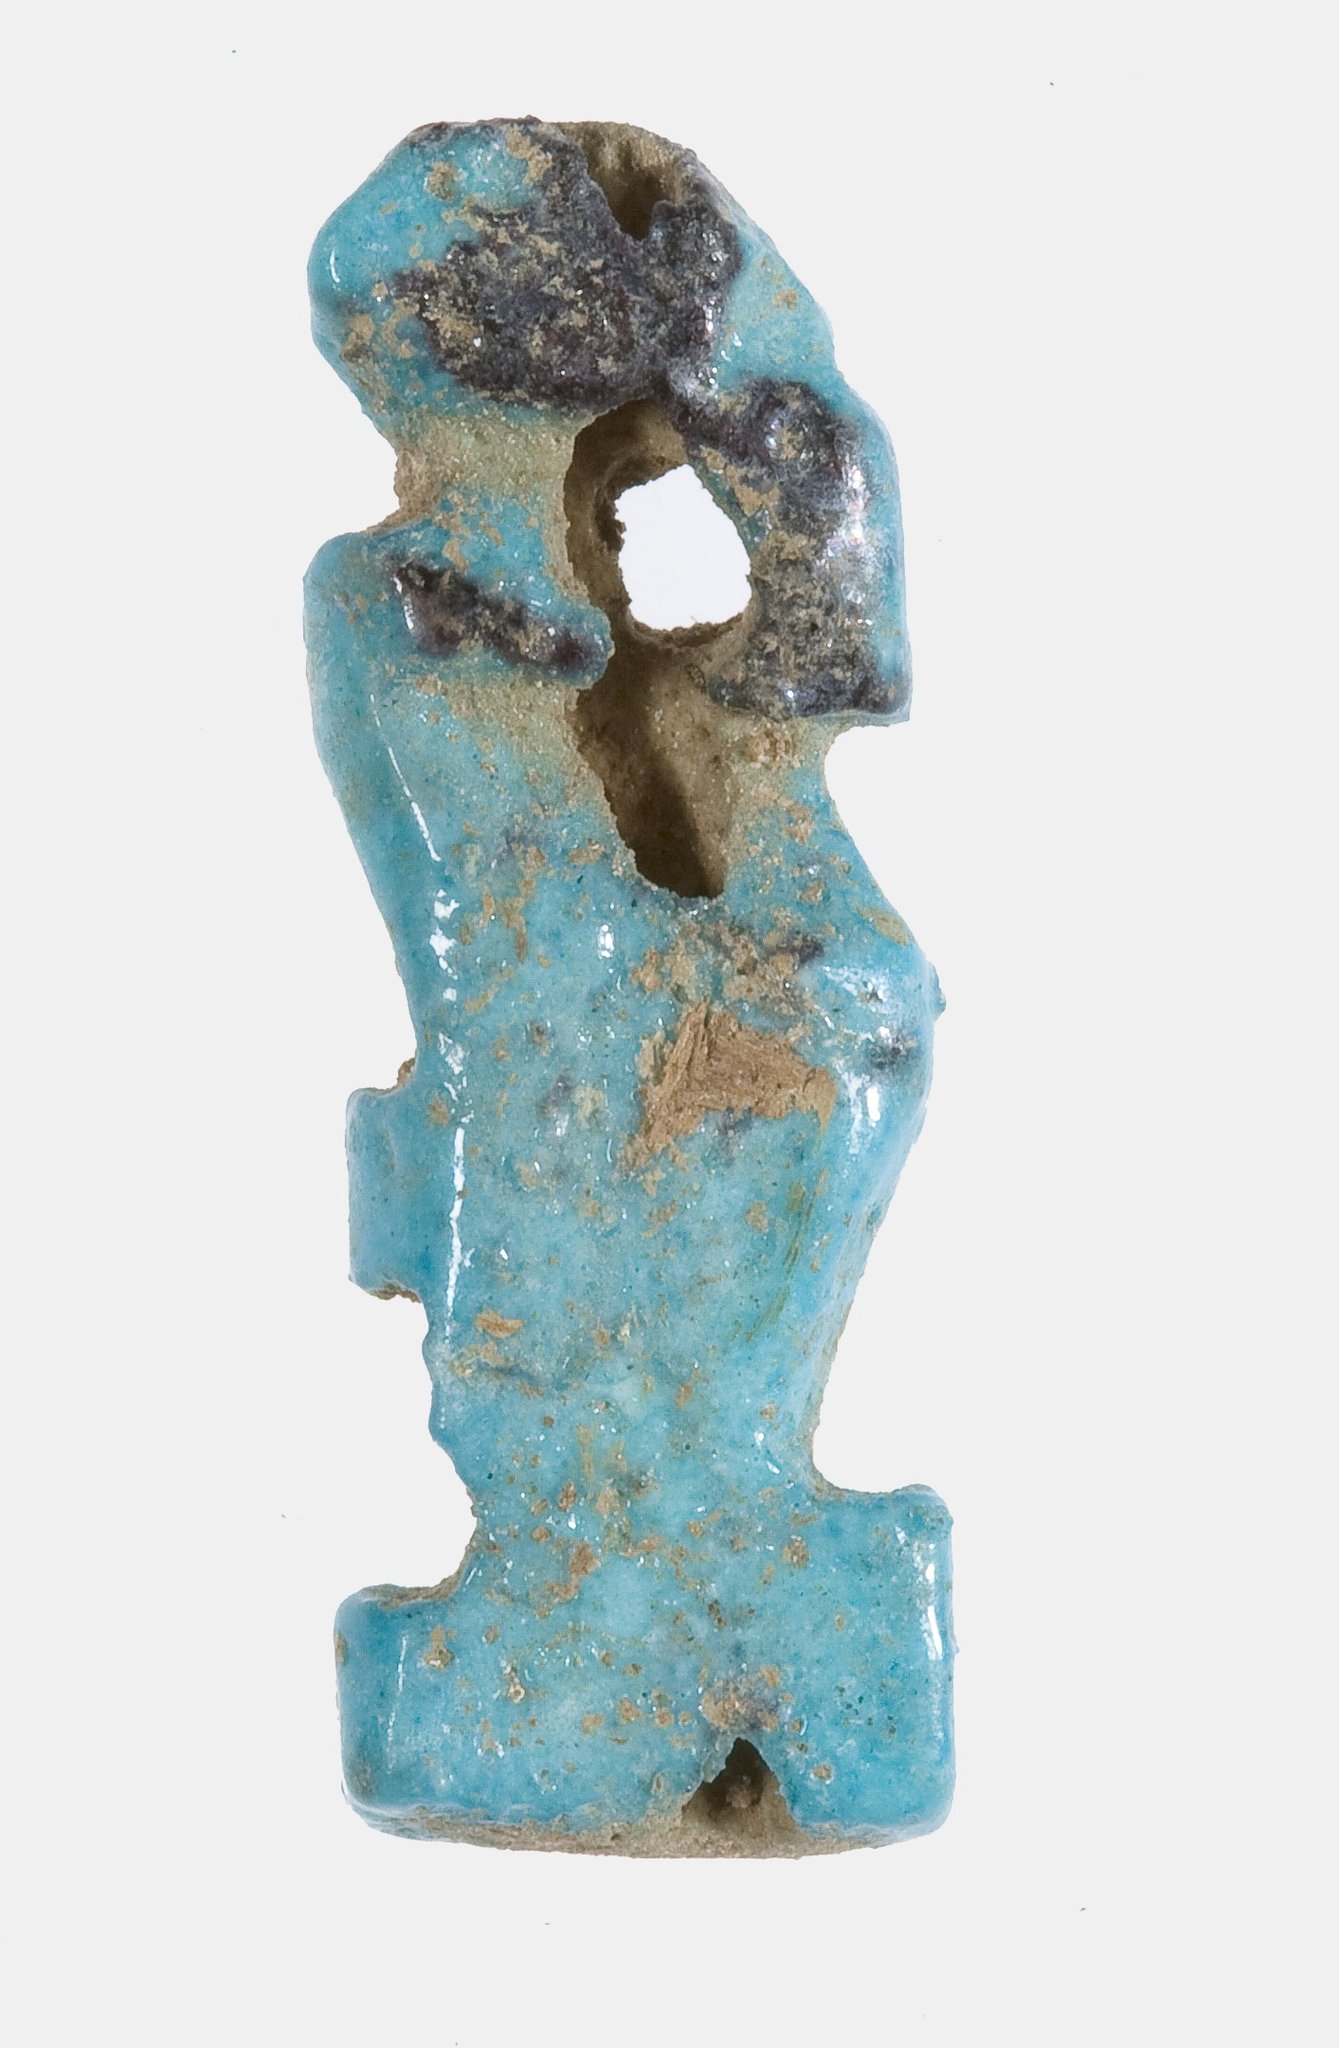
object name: necklace, bead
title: Amulet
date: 1802-1450 BCE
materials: faience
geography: egypt